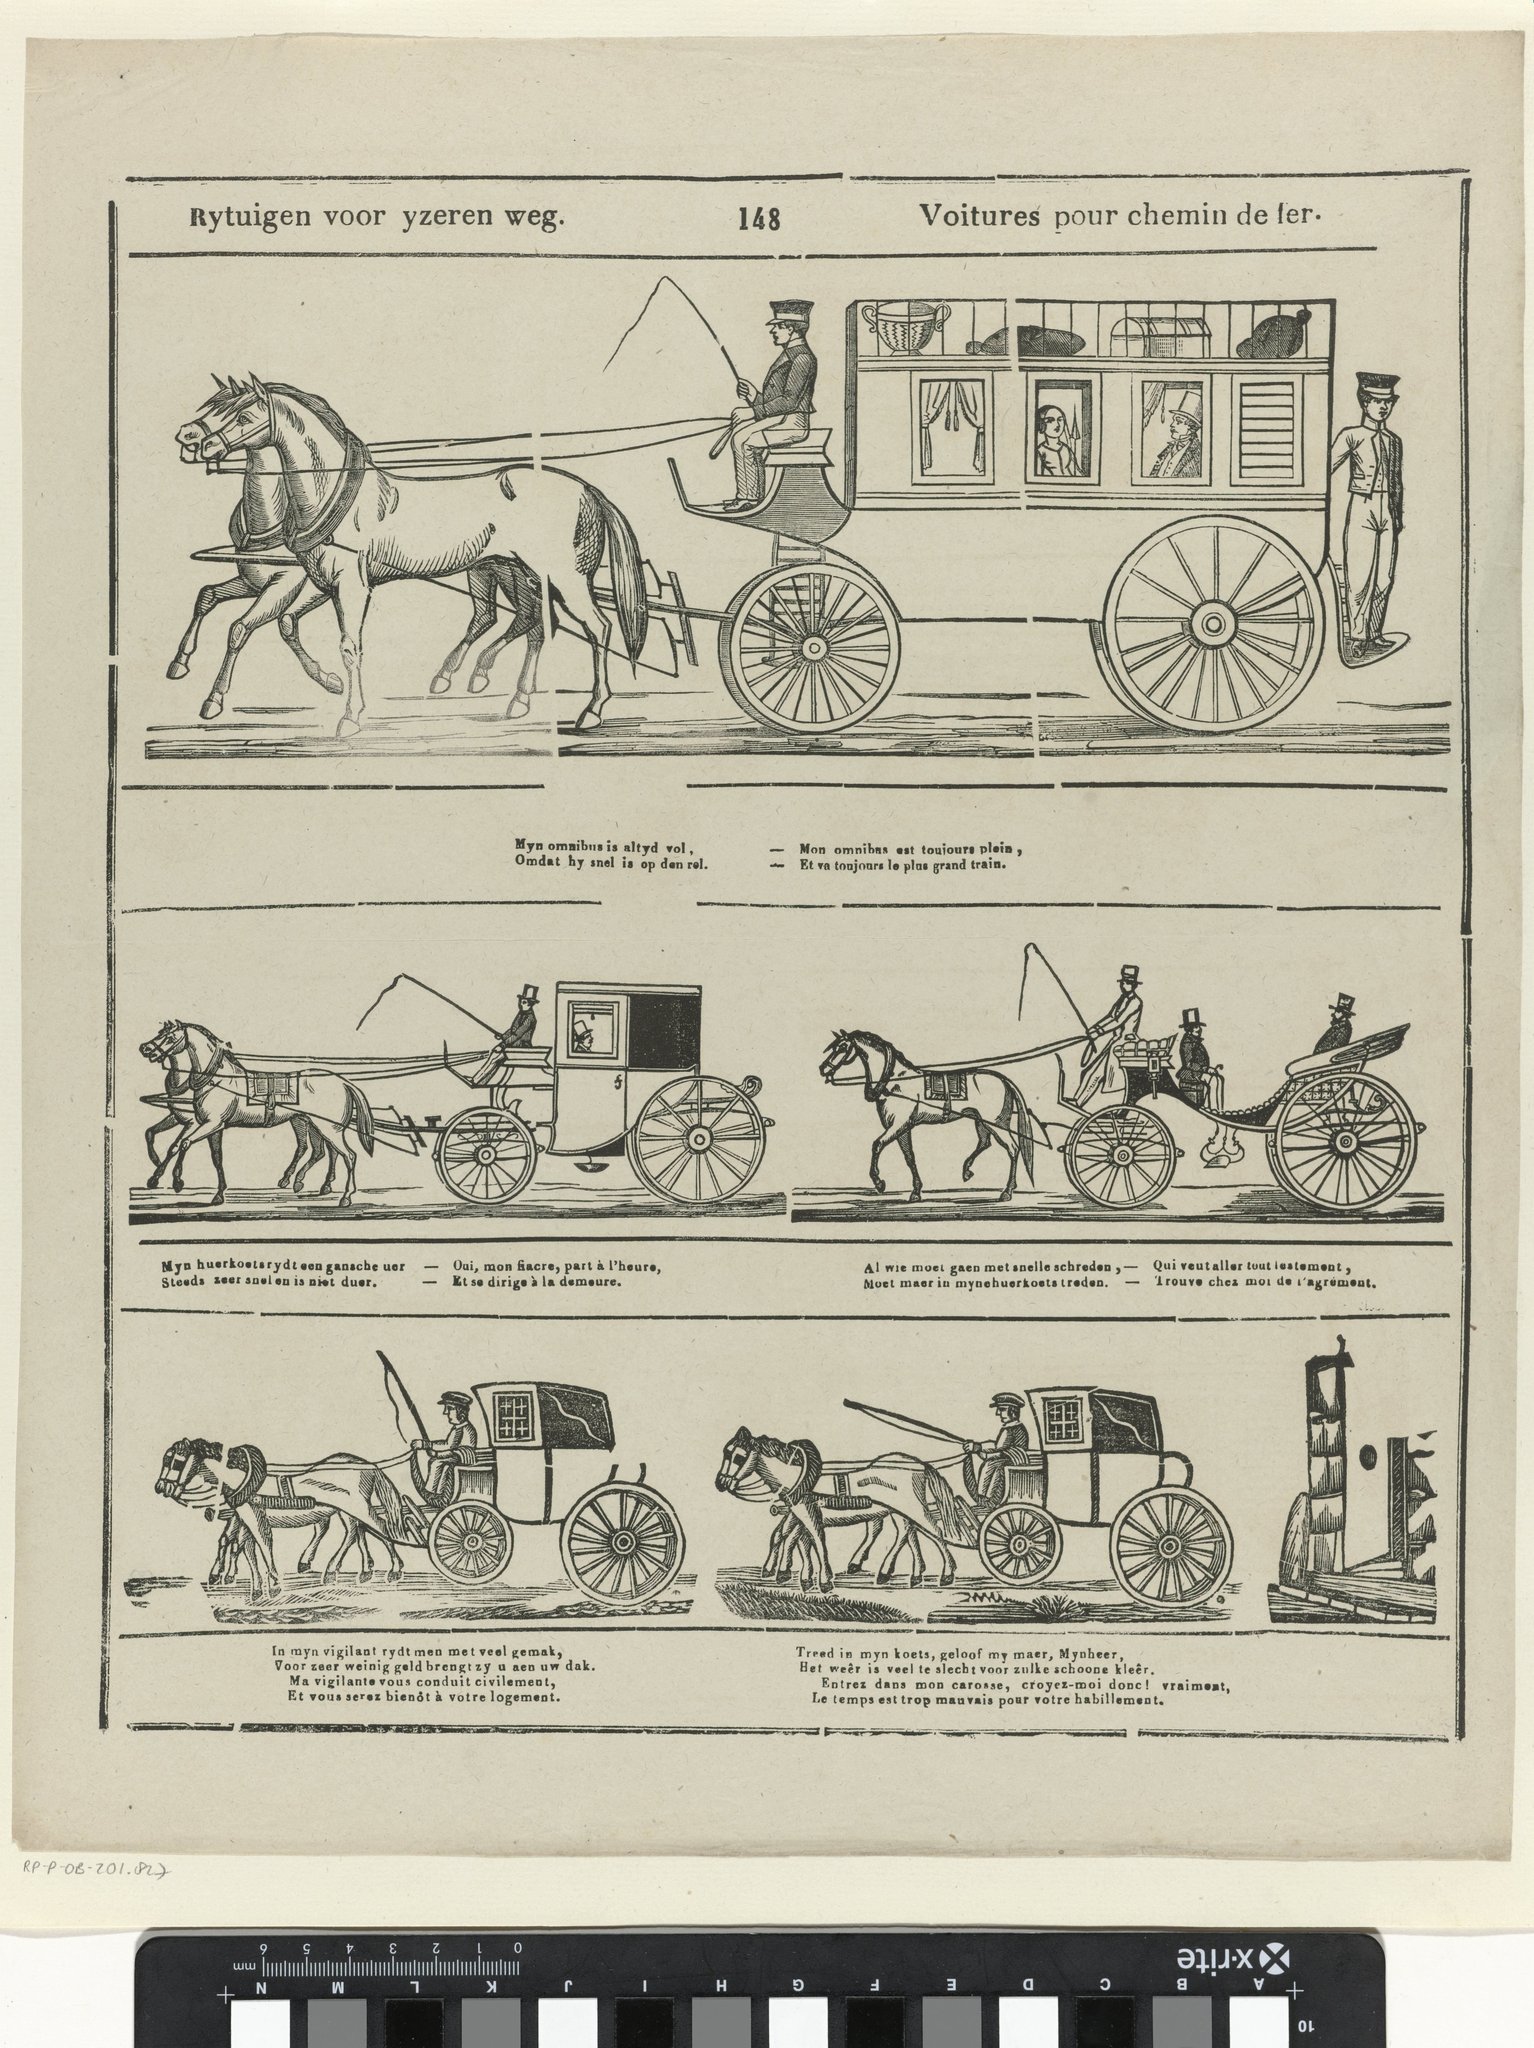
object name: popular print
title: Rytuigen voor yzeren weg / Voitures pour chemin de fer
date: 1800-1833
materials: paper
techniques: letterpress printing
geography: turnhout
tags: four-wheeled, animal-drawn vehicle, e.g.: cab, carriage, coach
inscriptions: collector's mark: Lugt 2760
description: Blad met 3 horizontale rijen met in totaal 5 voorstellingen van verschillende rijtuigen. Onder elke afbeelding een onderschrift in het Nederlands en in het Frans. Genummerd midden boven: 148.